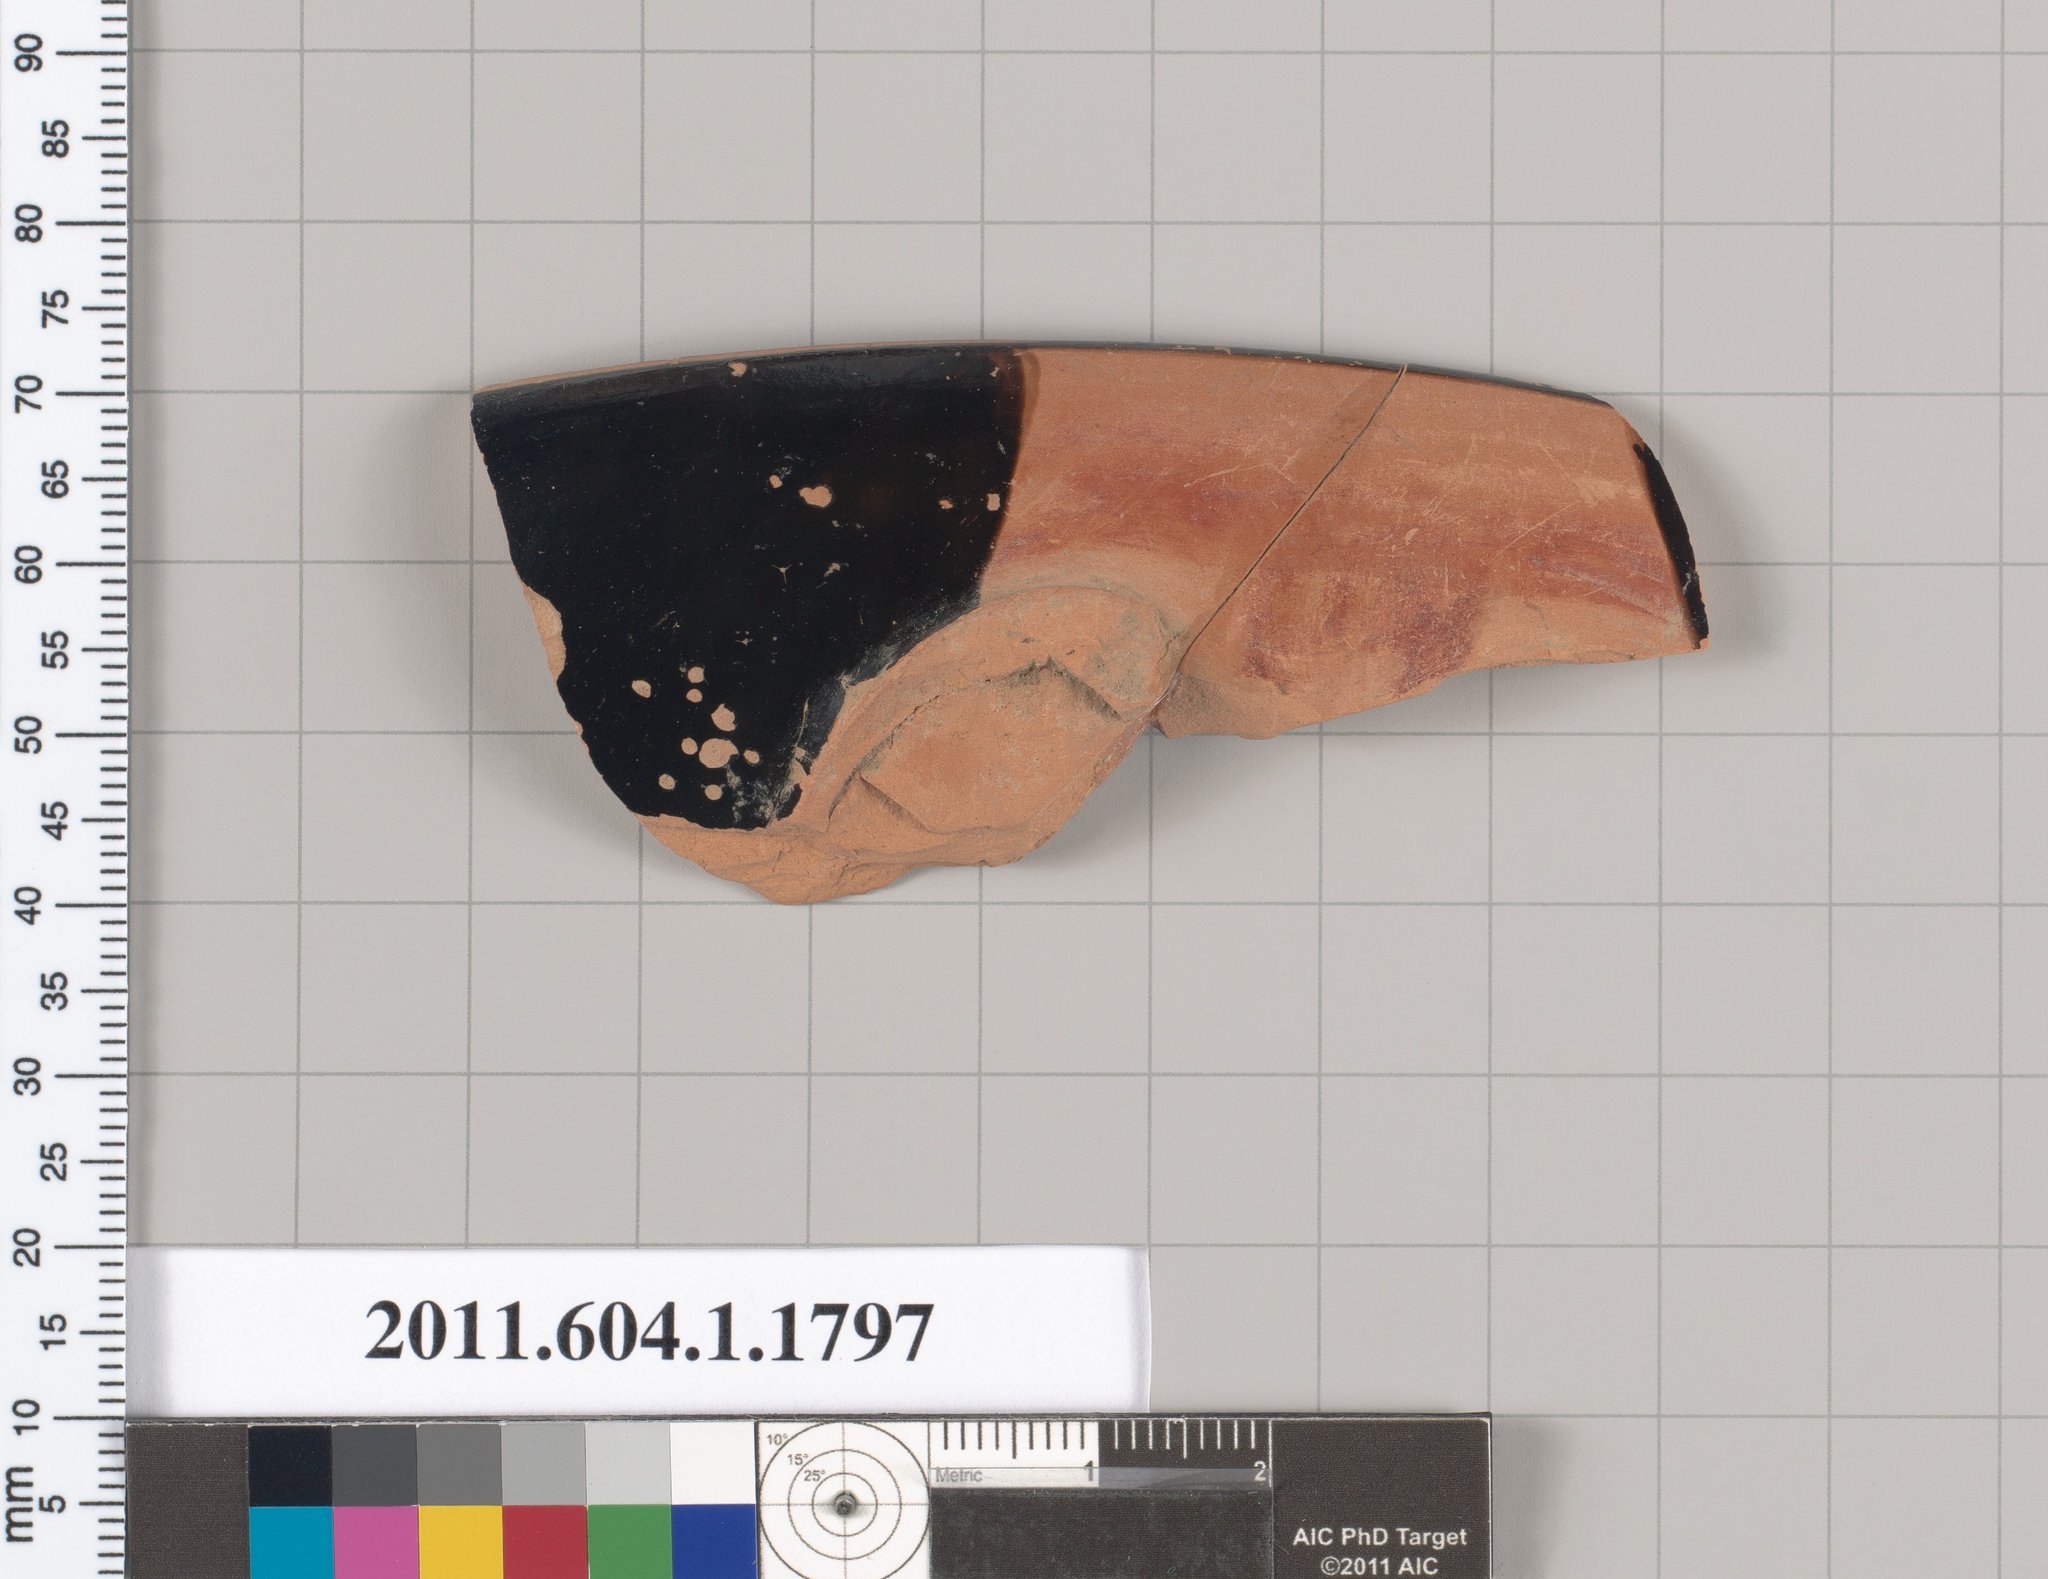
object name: kylix fragment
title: Terracotta rim fragment of a kylix (drinking cup)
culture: greek, attic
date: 500-401 BCE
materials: terracotta